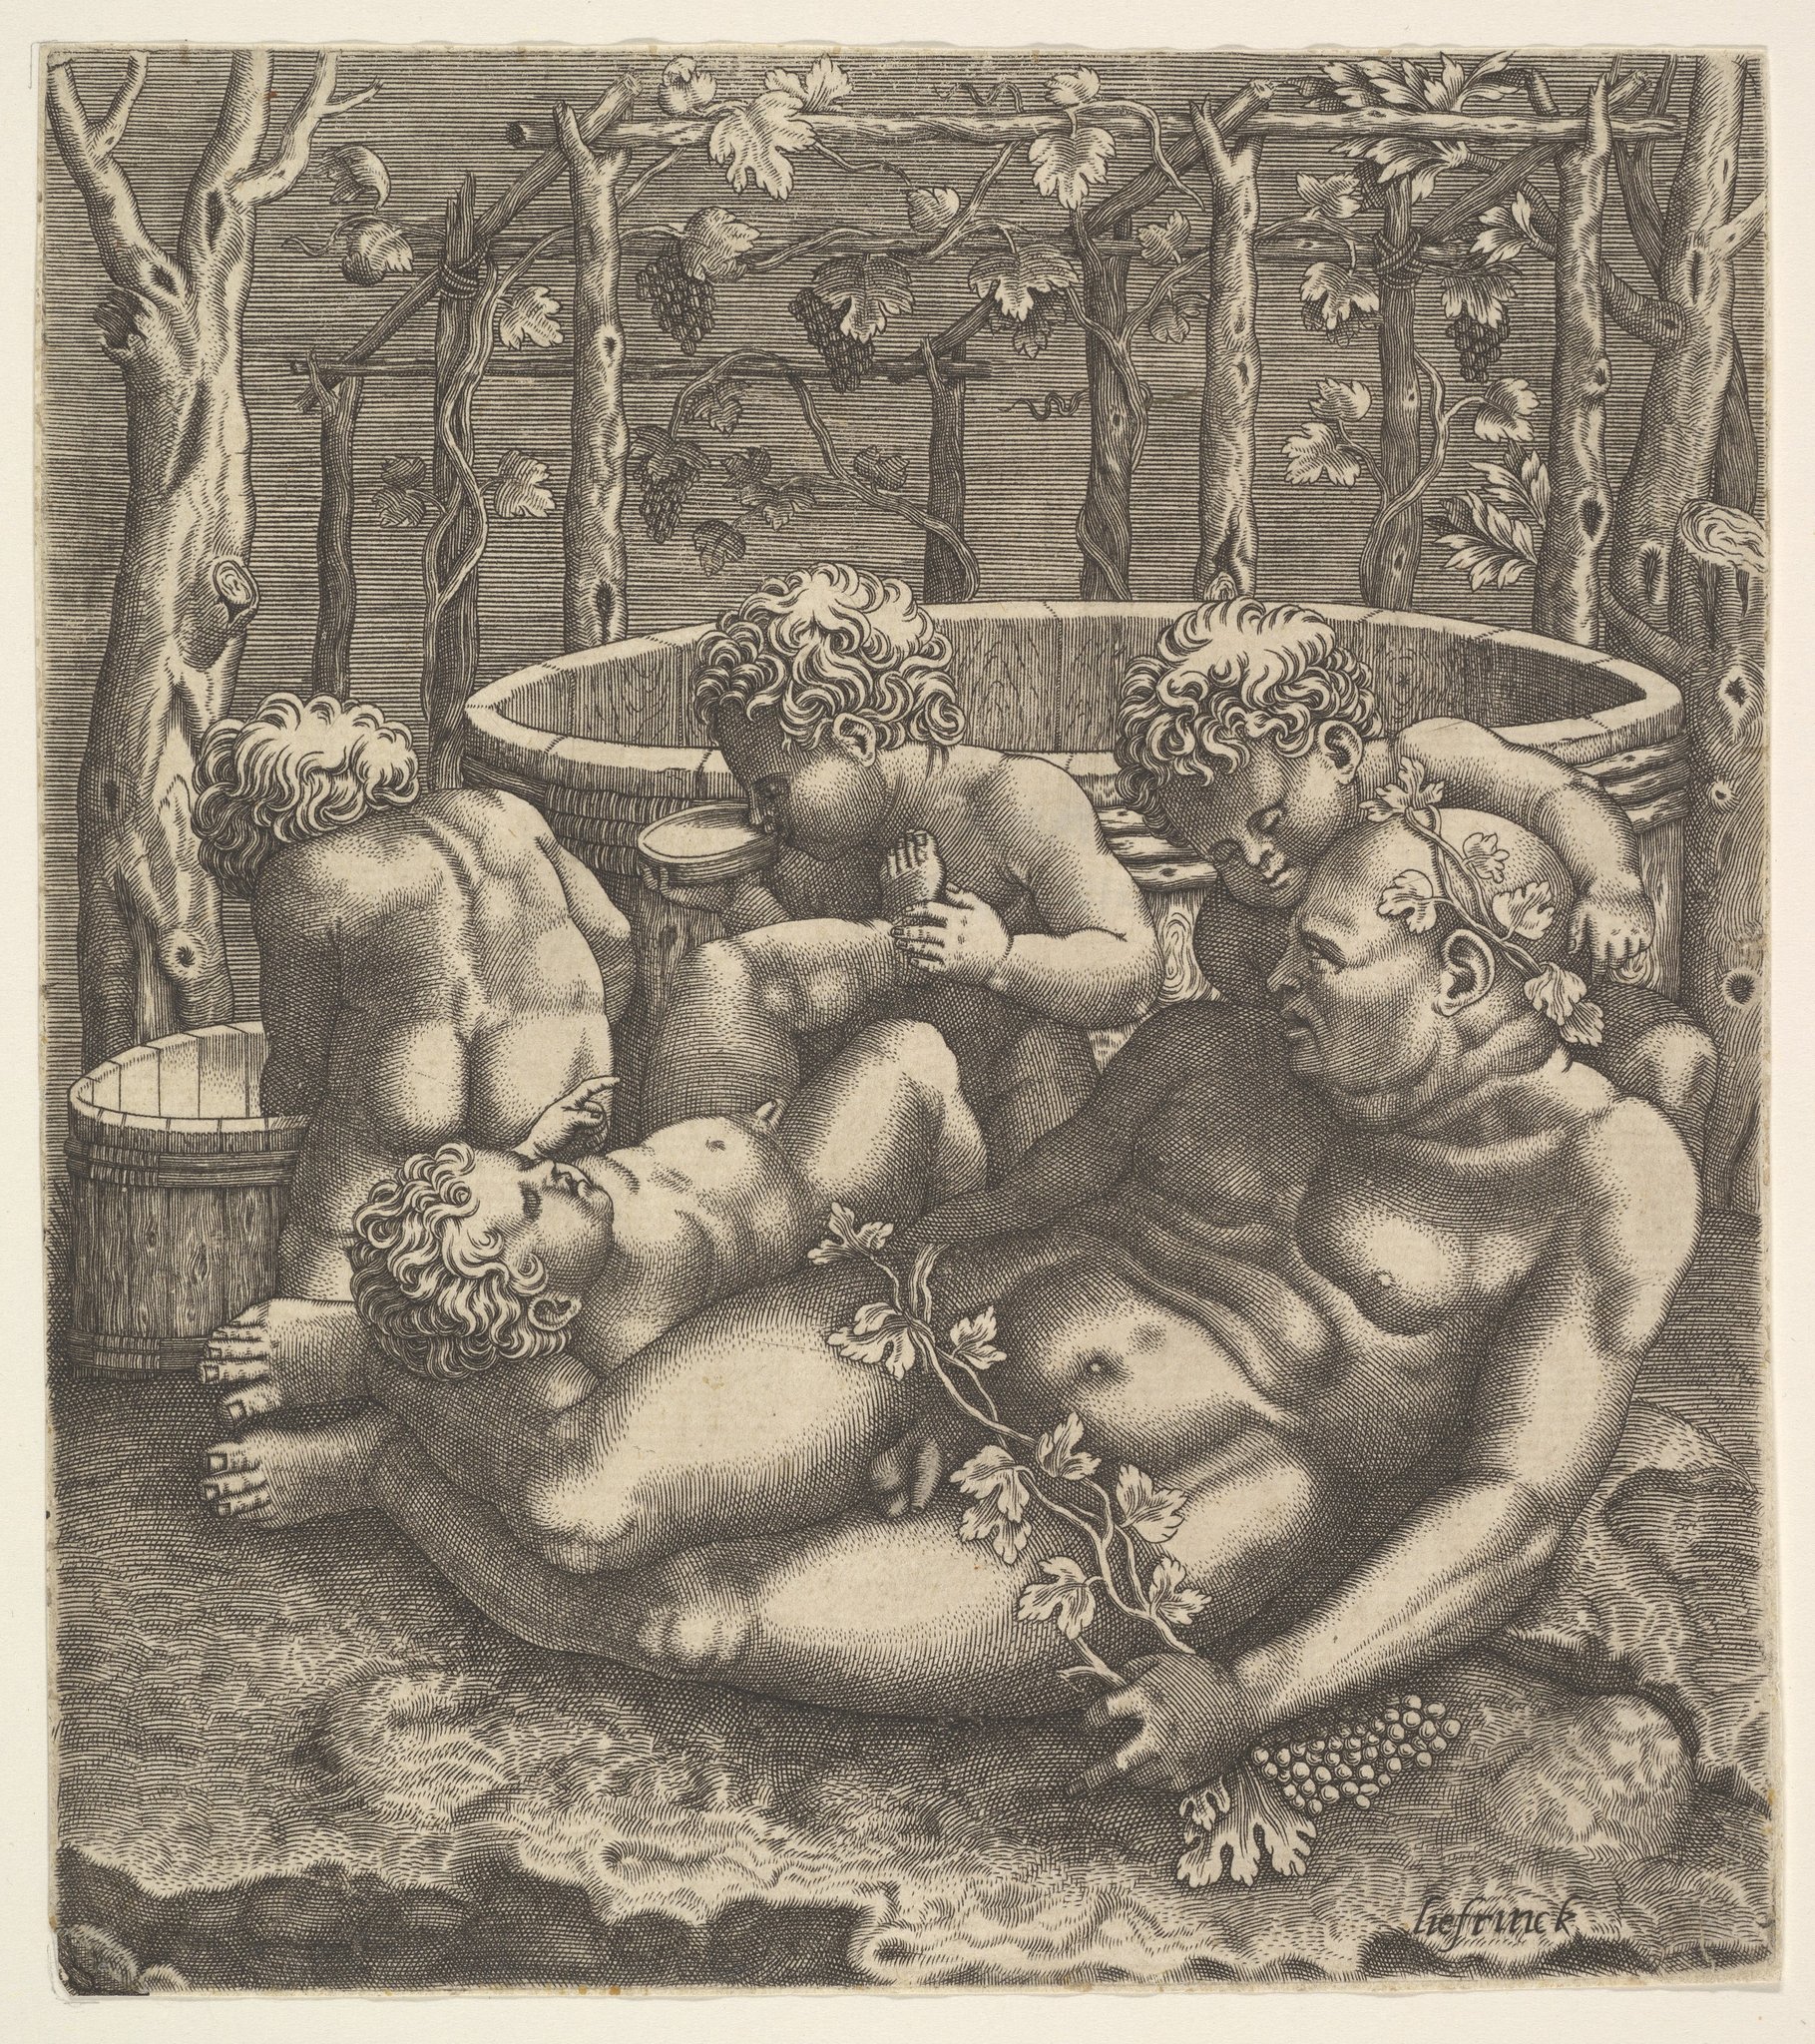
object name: print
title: Silenus reclining before wine vats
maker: philippe de soye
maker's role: artist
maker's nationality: netherlandish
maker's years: 1538-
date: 1558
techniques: engraving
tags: grapes,boys,male nudes,silenus,vines